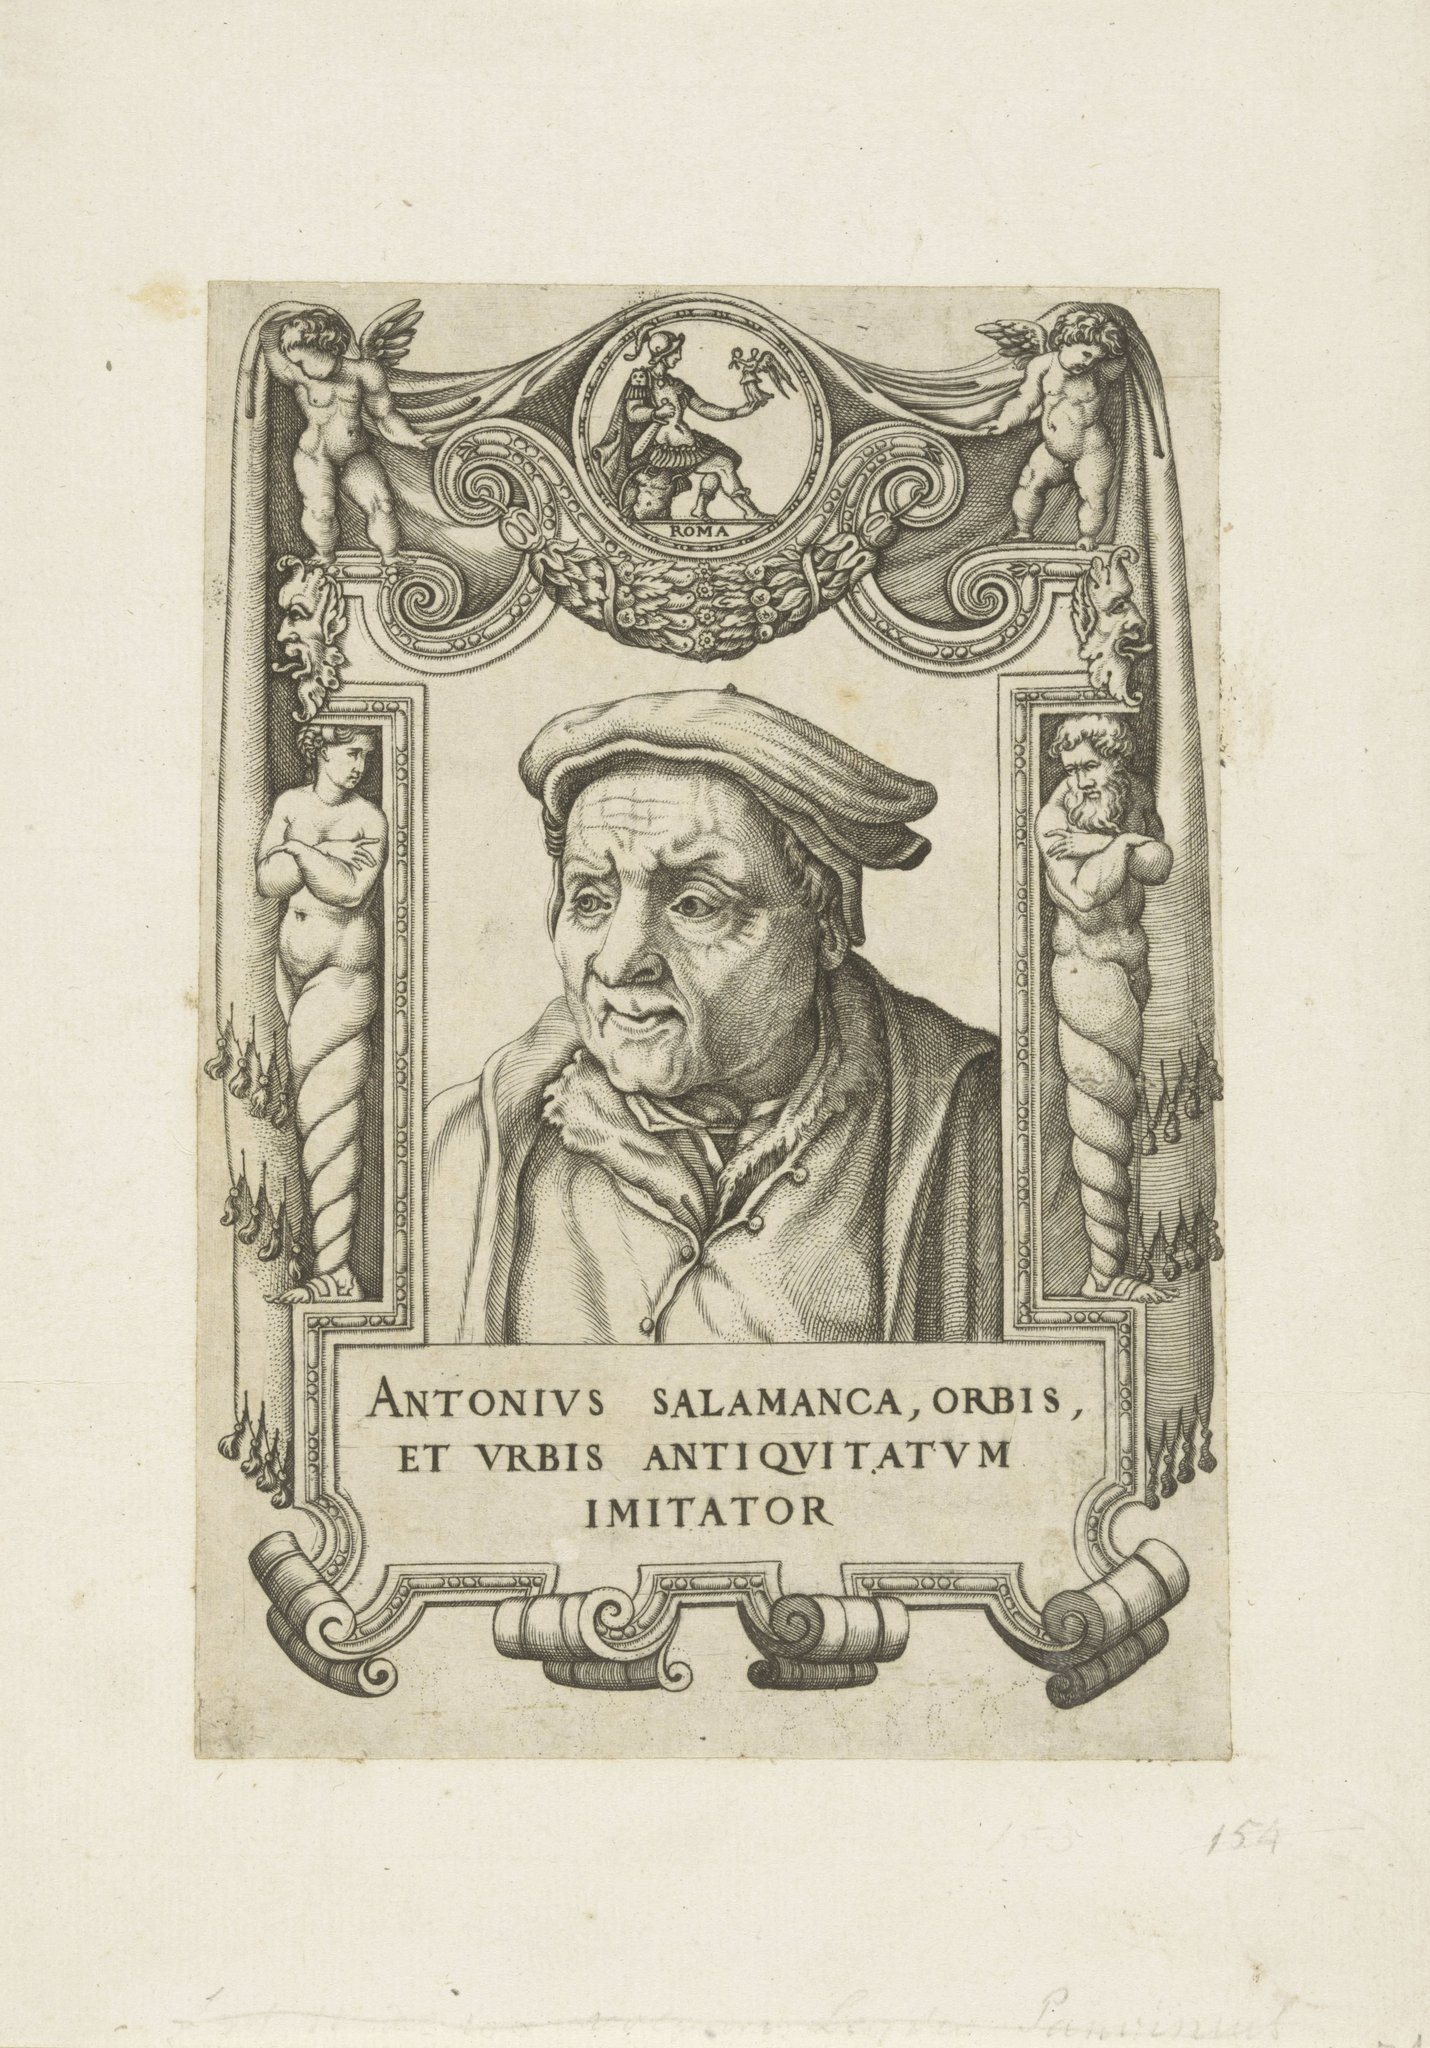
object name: print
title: Portret van uitgever Antonio Salamanca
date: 1517-1565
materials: paper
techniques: engraving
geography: rome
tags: antonio salamanca, historical persons, portrait, self-portrait of artist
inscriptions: collector's mark: Lugt 240